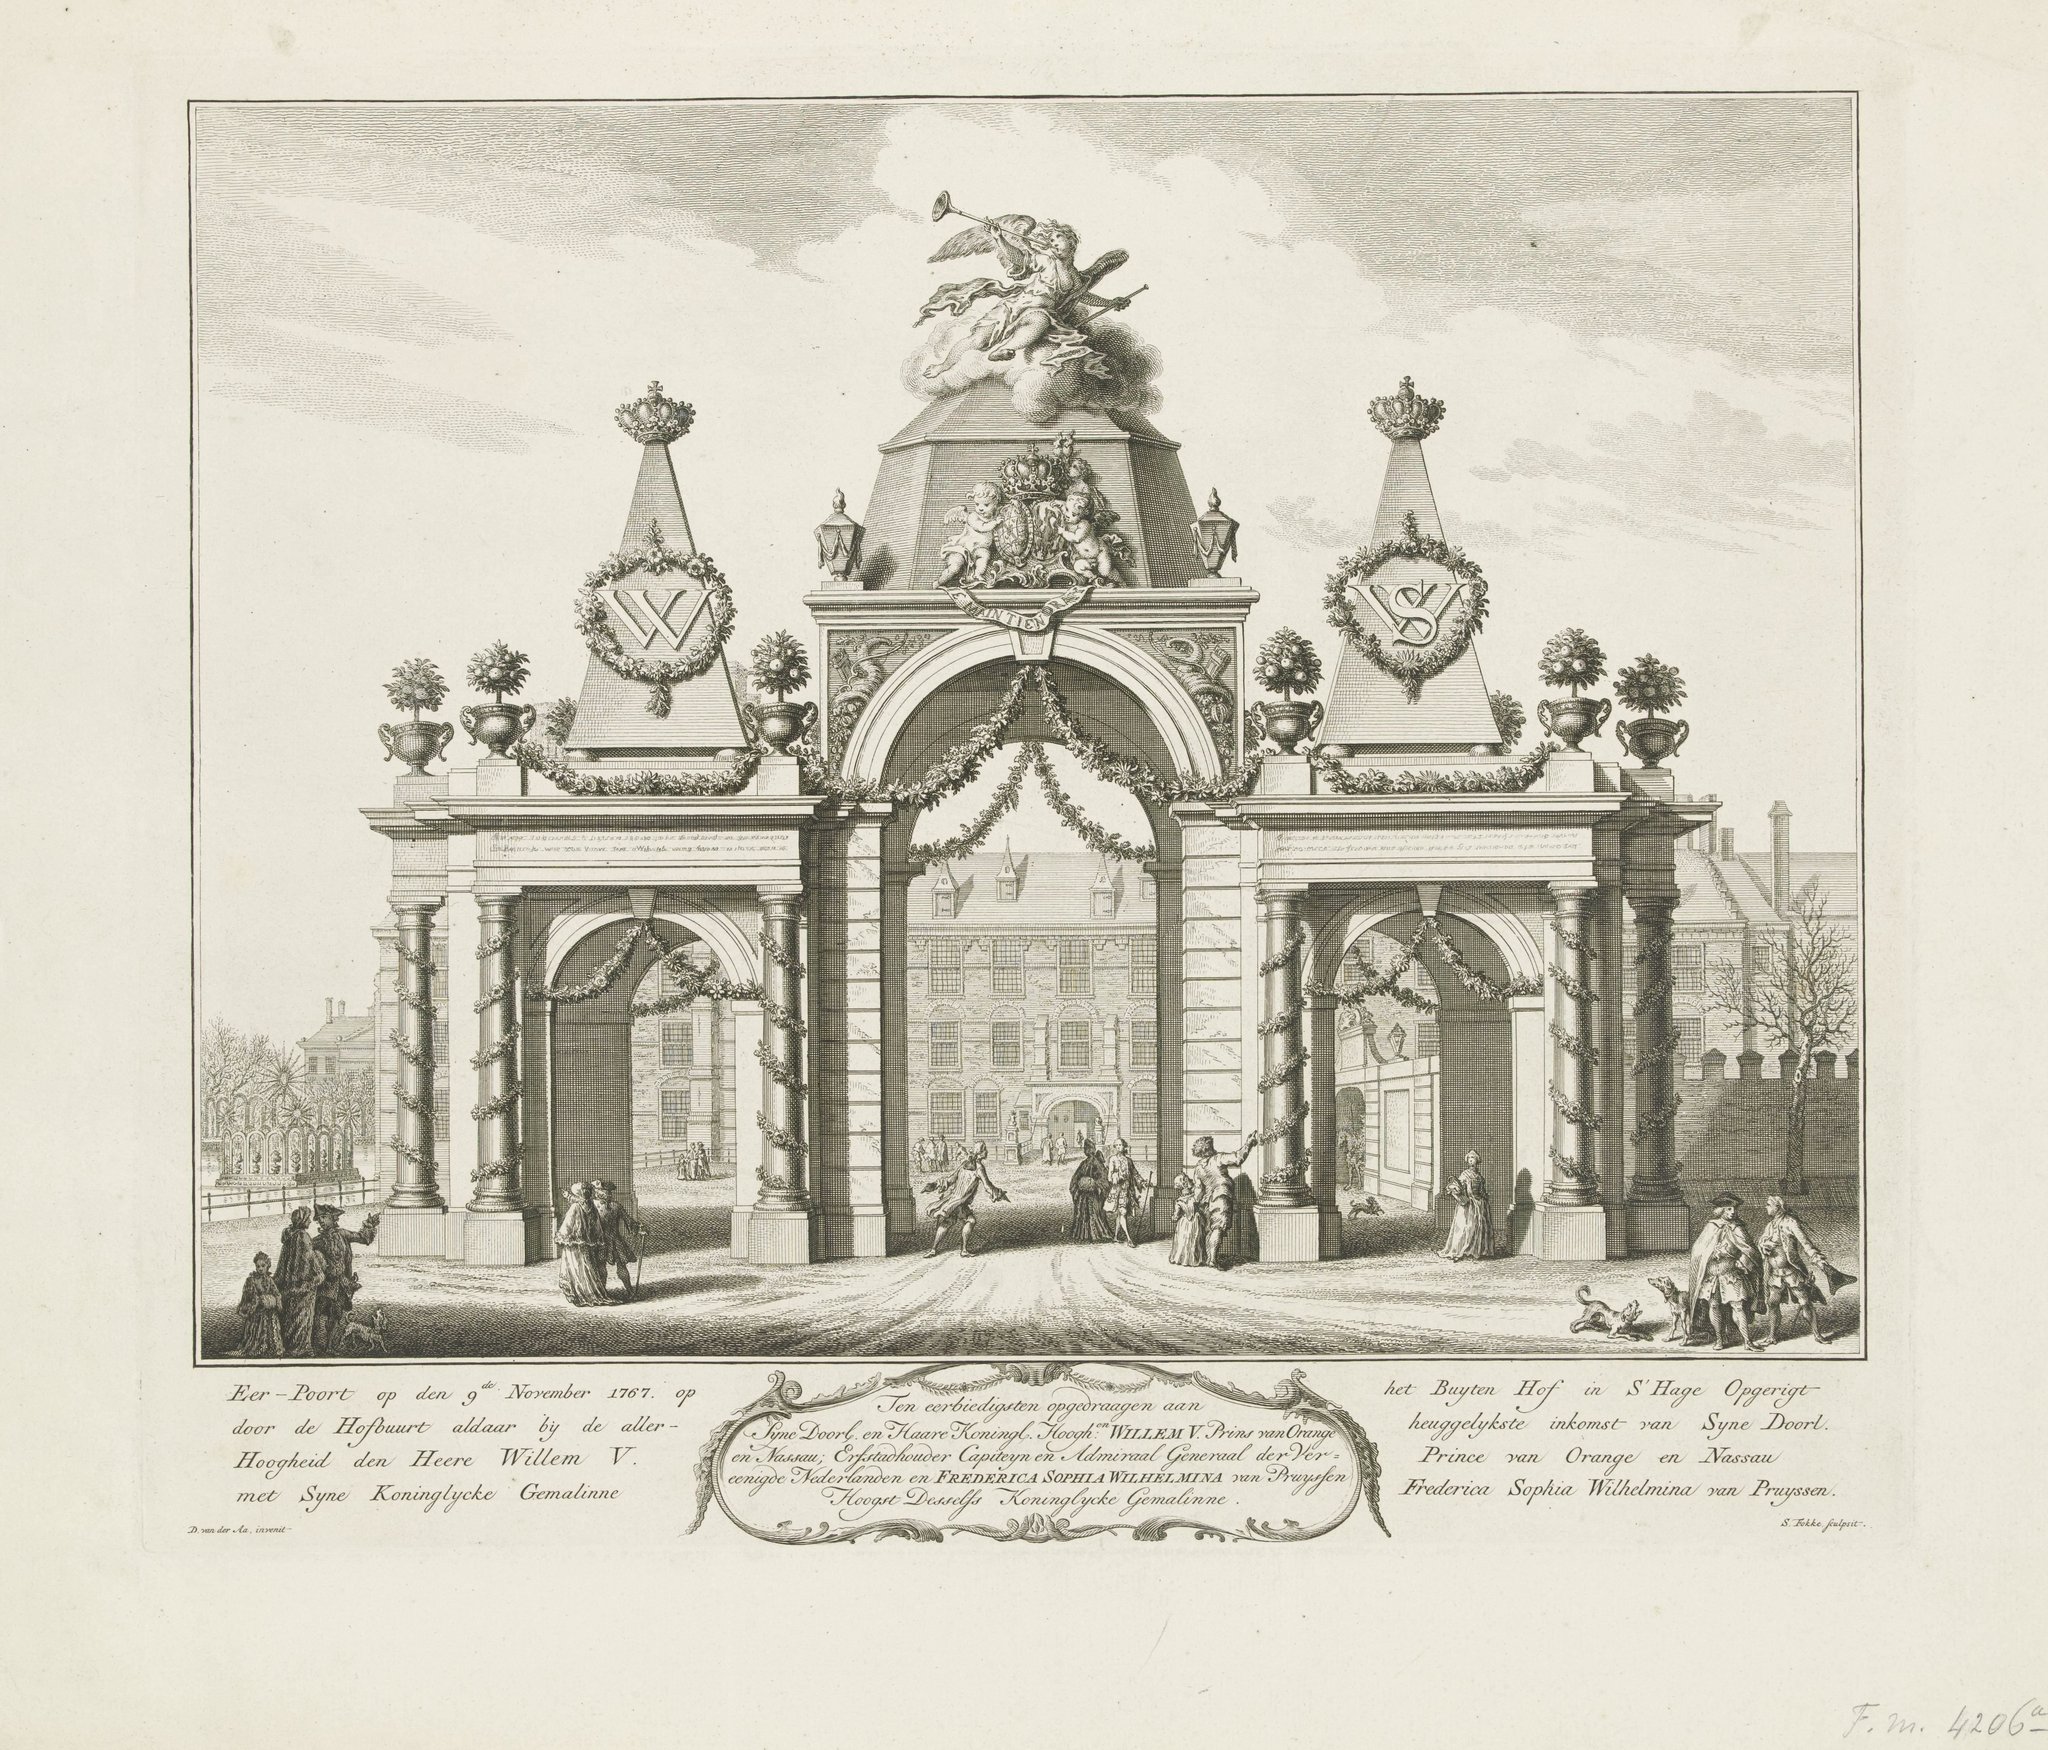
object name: print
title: Eer-Poort op den 9de November op het Buyten Hof in S'Hage Opgerigt door de Hofbuurt aldaar by de allerheuggelykste inkomst van Syne Doorl. Hoogheid den Heere Willem V. Prince van Orange en Nassau met Syne Koninglycke Gemalinne Frederica Sophia Wilhelmina van Pruyssen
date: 1767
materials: paper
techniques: engraving, etching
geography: northern netherlands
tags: the hague, william v (prince of orange), berlin, painter, draughtsman, wilhelmina of prussia (princess of orange), triumphal arch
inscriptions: collector's mark: Lugt 2228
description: Gezicht op de erepoort opgericht op het Buitenhof voor de intrede van de pas getrouwde stadhouder Willem V en zijn echtgenote prinses Wilhelmina van Pruisen te Den Haag op 9 november 1767. In de marge een cartouche met de opdracht.